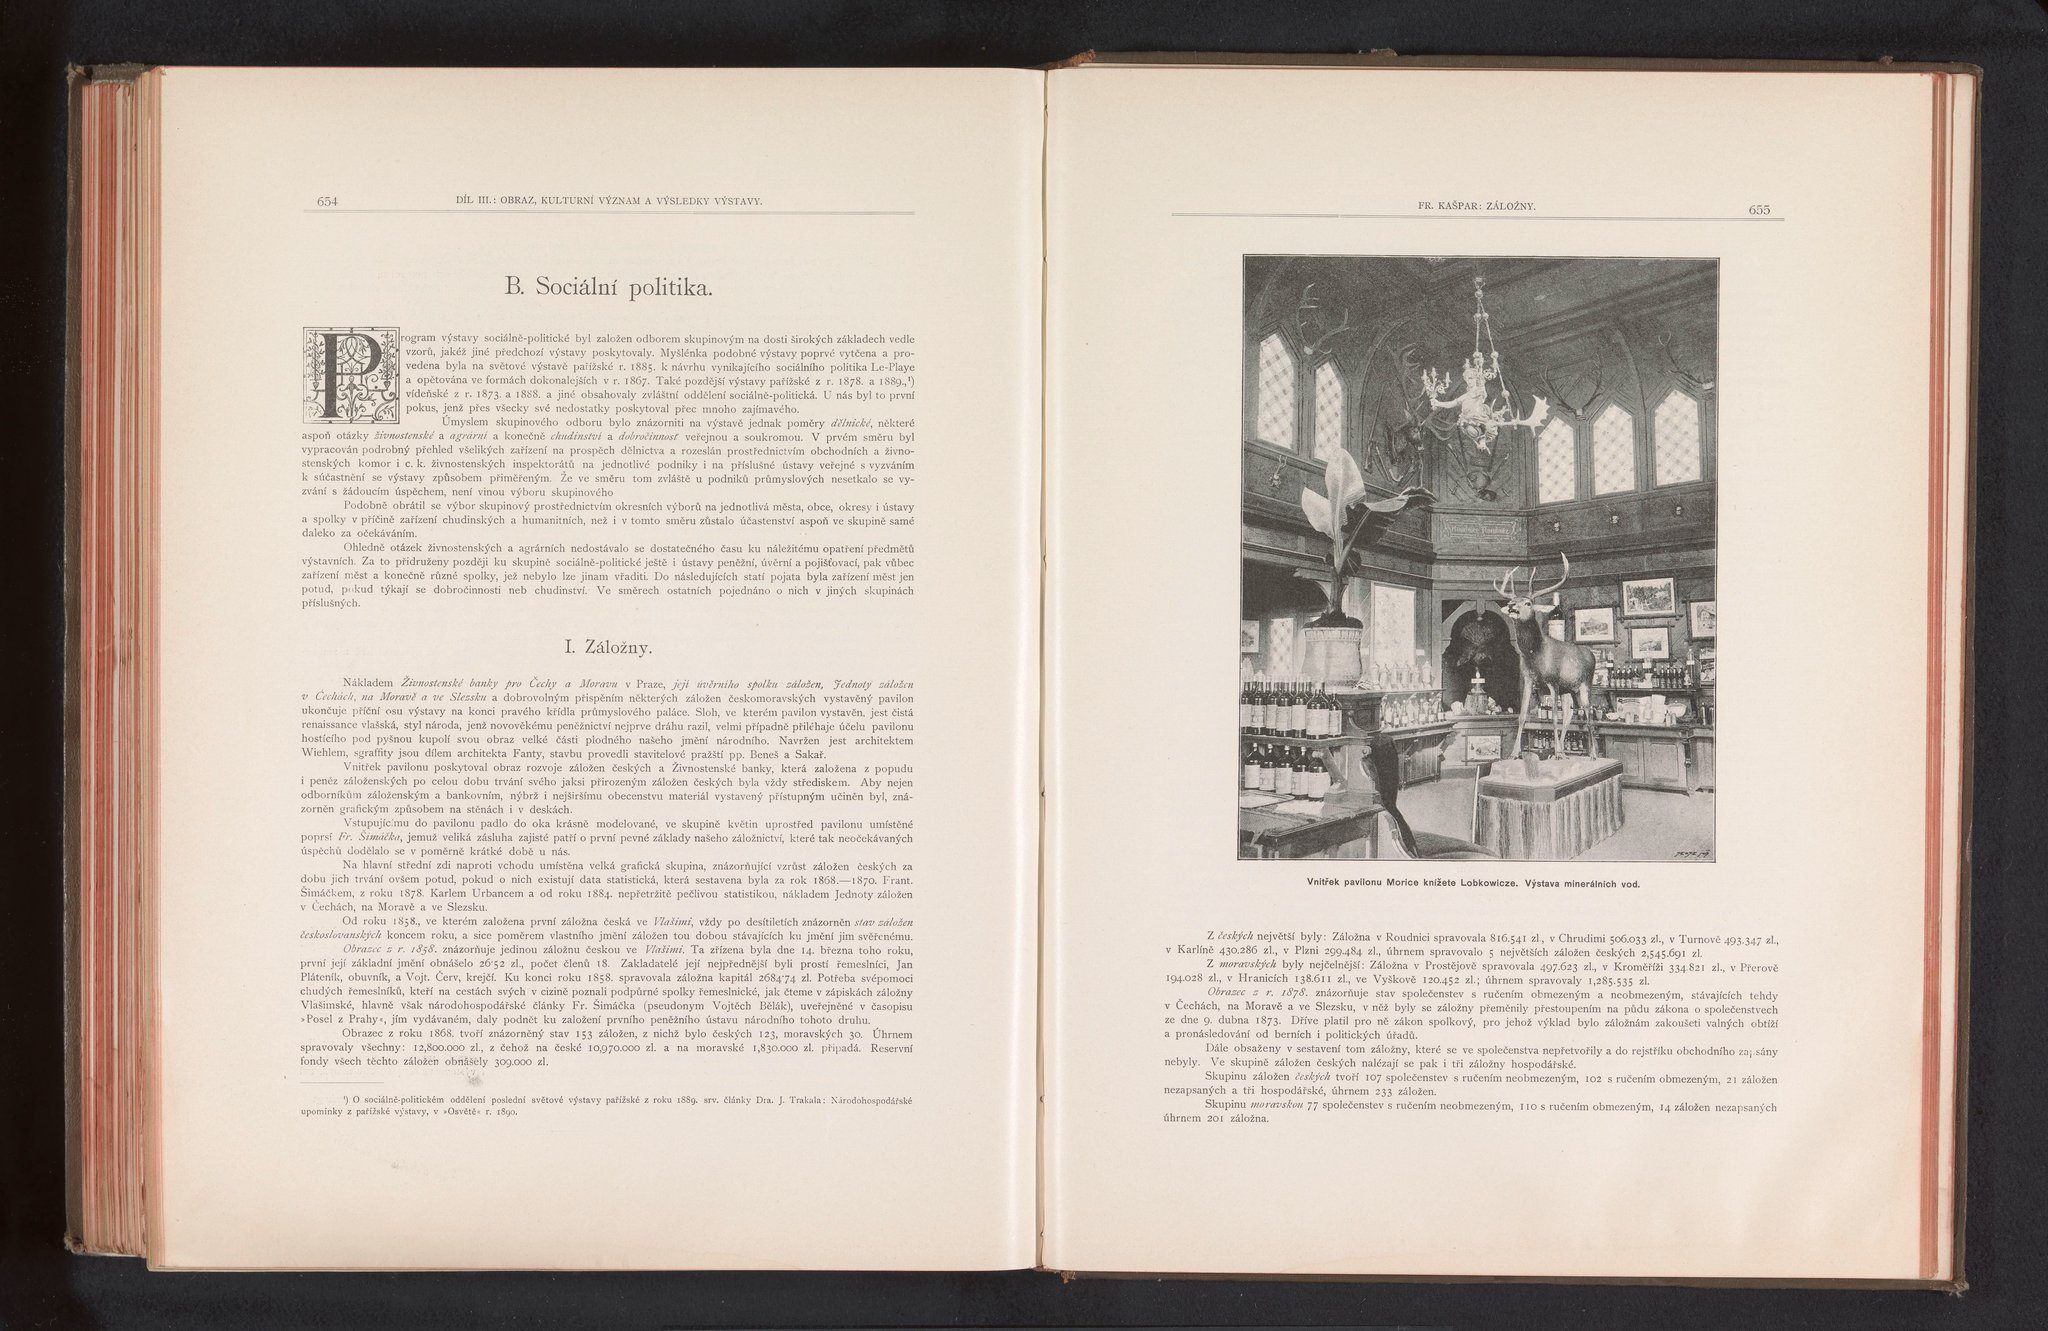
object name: photomechanical print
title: Vnitrek pavilonu Morice knizete Lobkowicze. Výstava mineralnich vod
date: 1891-1895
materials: paper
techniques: autotype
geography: výstaviště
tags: mineral water, interior ~ representation of a building, collection, exhibition, show